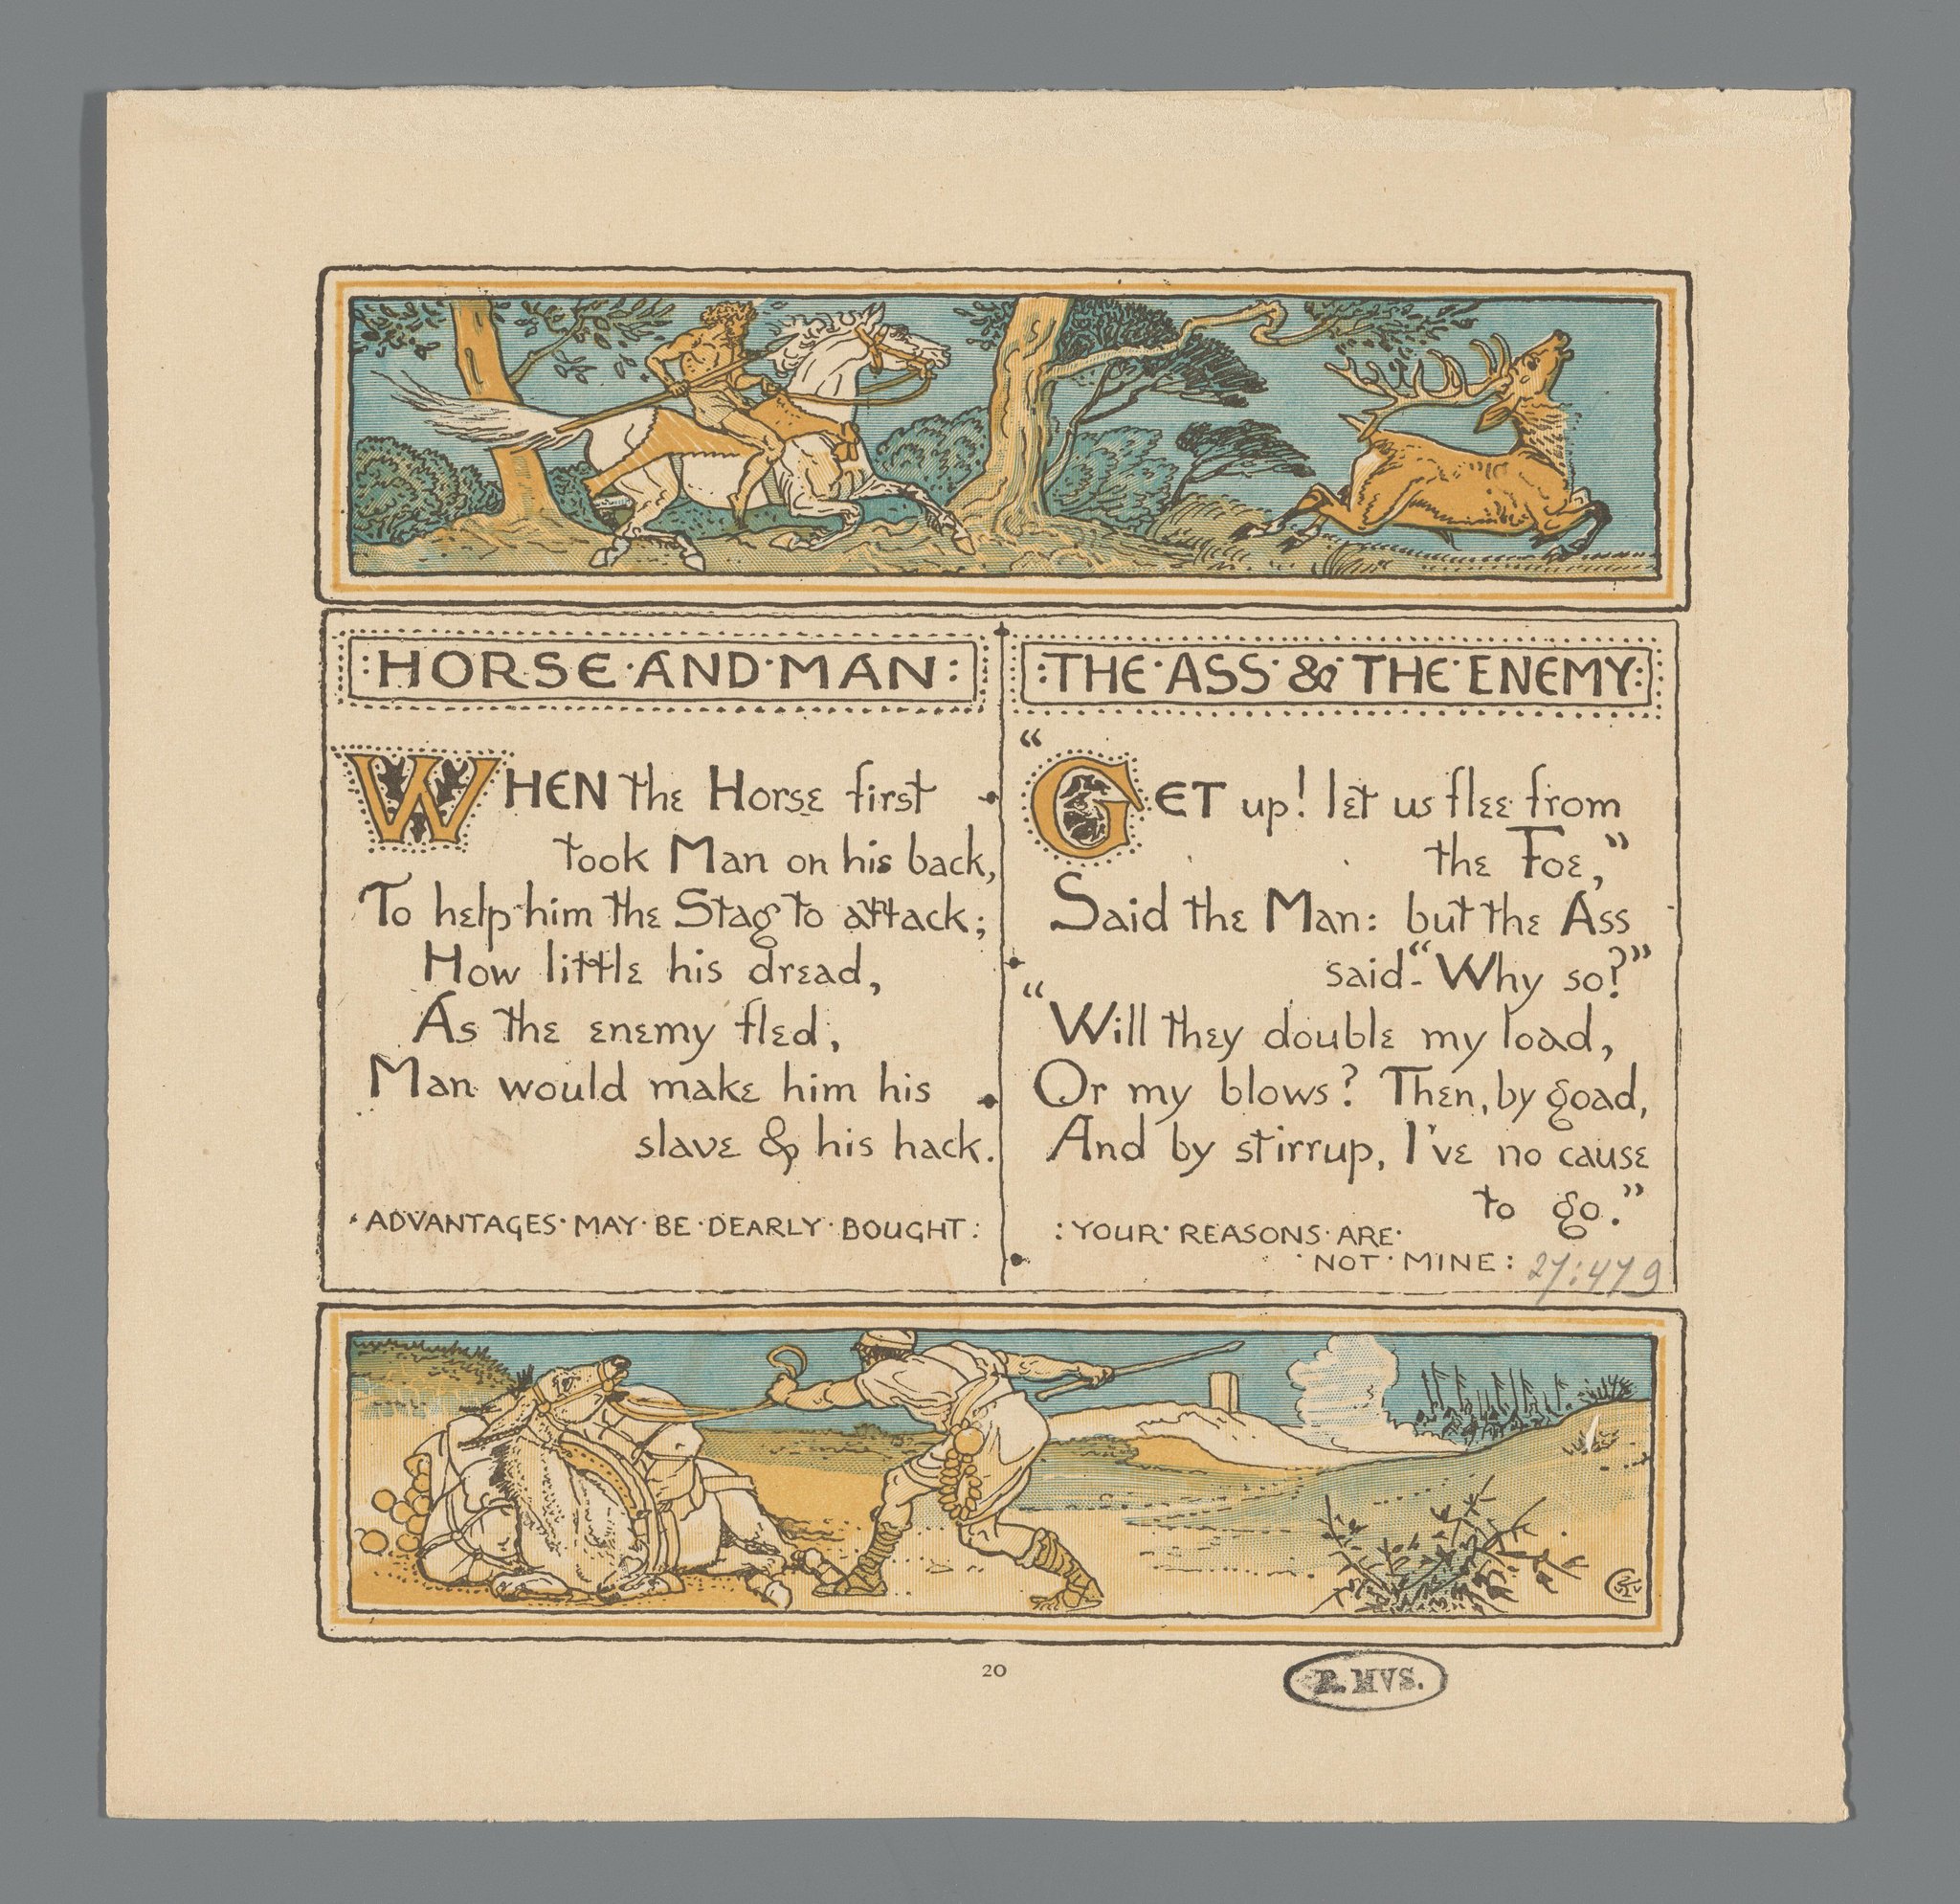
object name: book illustration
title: The ass & the enemy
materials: paper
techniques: wood engraving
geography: london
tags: hoofed animals: deer, ass, donkey, hunter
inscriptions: collector's mark: Lugt 2228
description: Prent uit: The baby's own Aesop being the fables condensed in rhyme. Londen: Routledge & Sons, 1887. Of een latere uitgave.